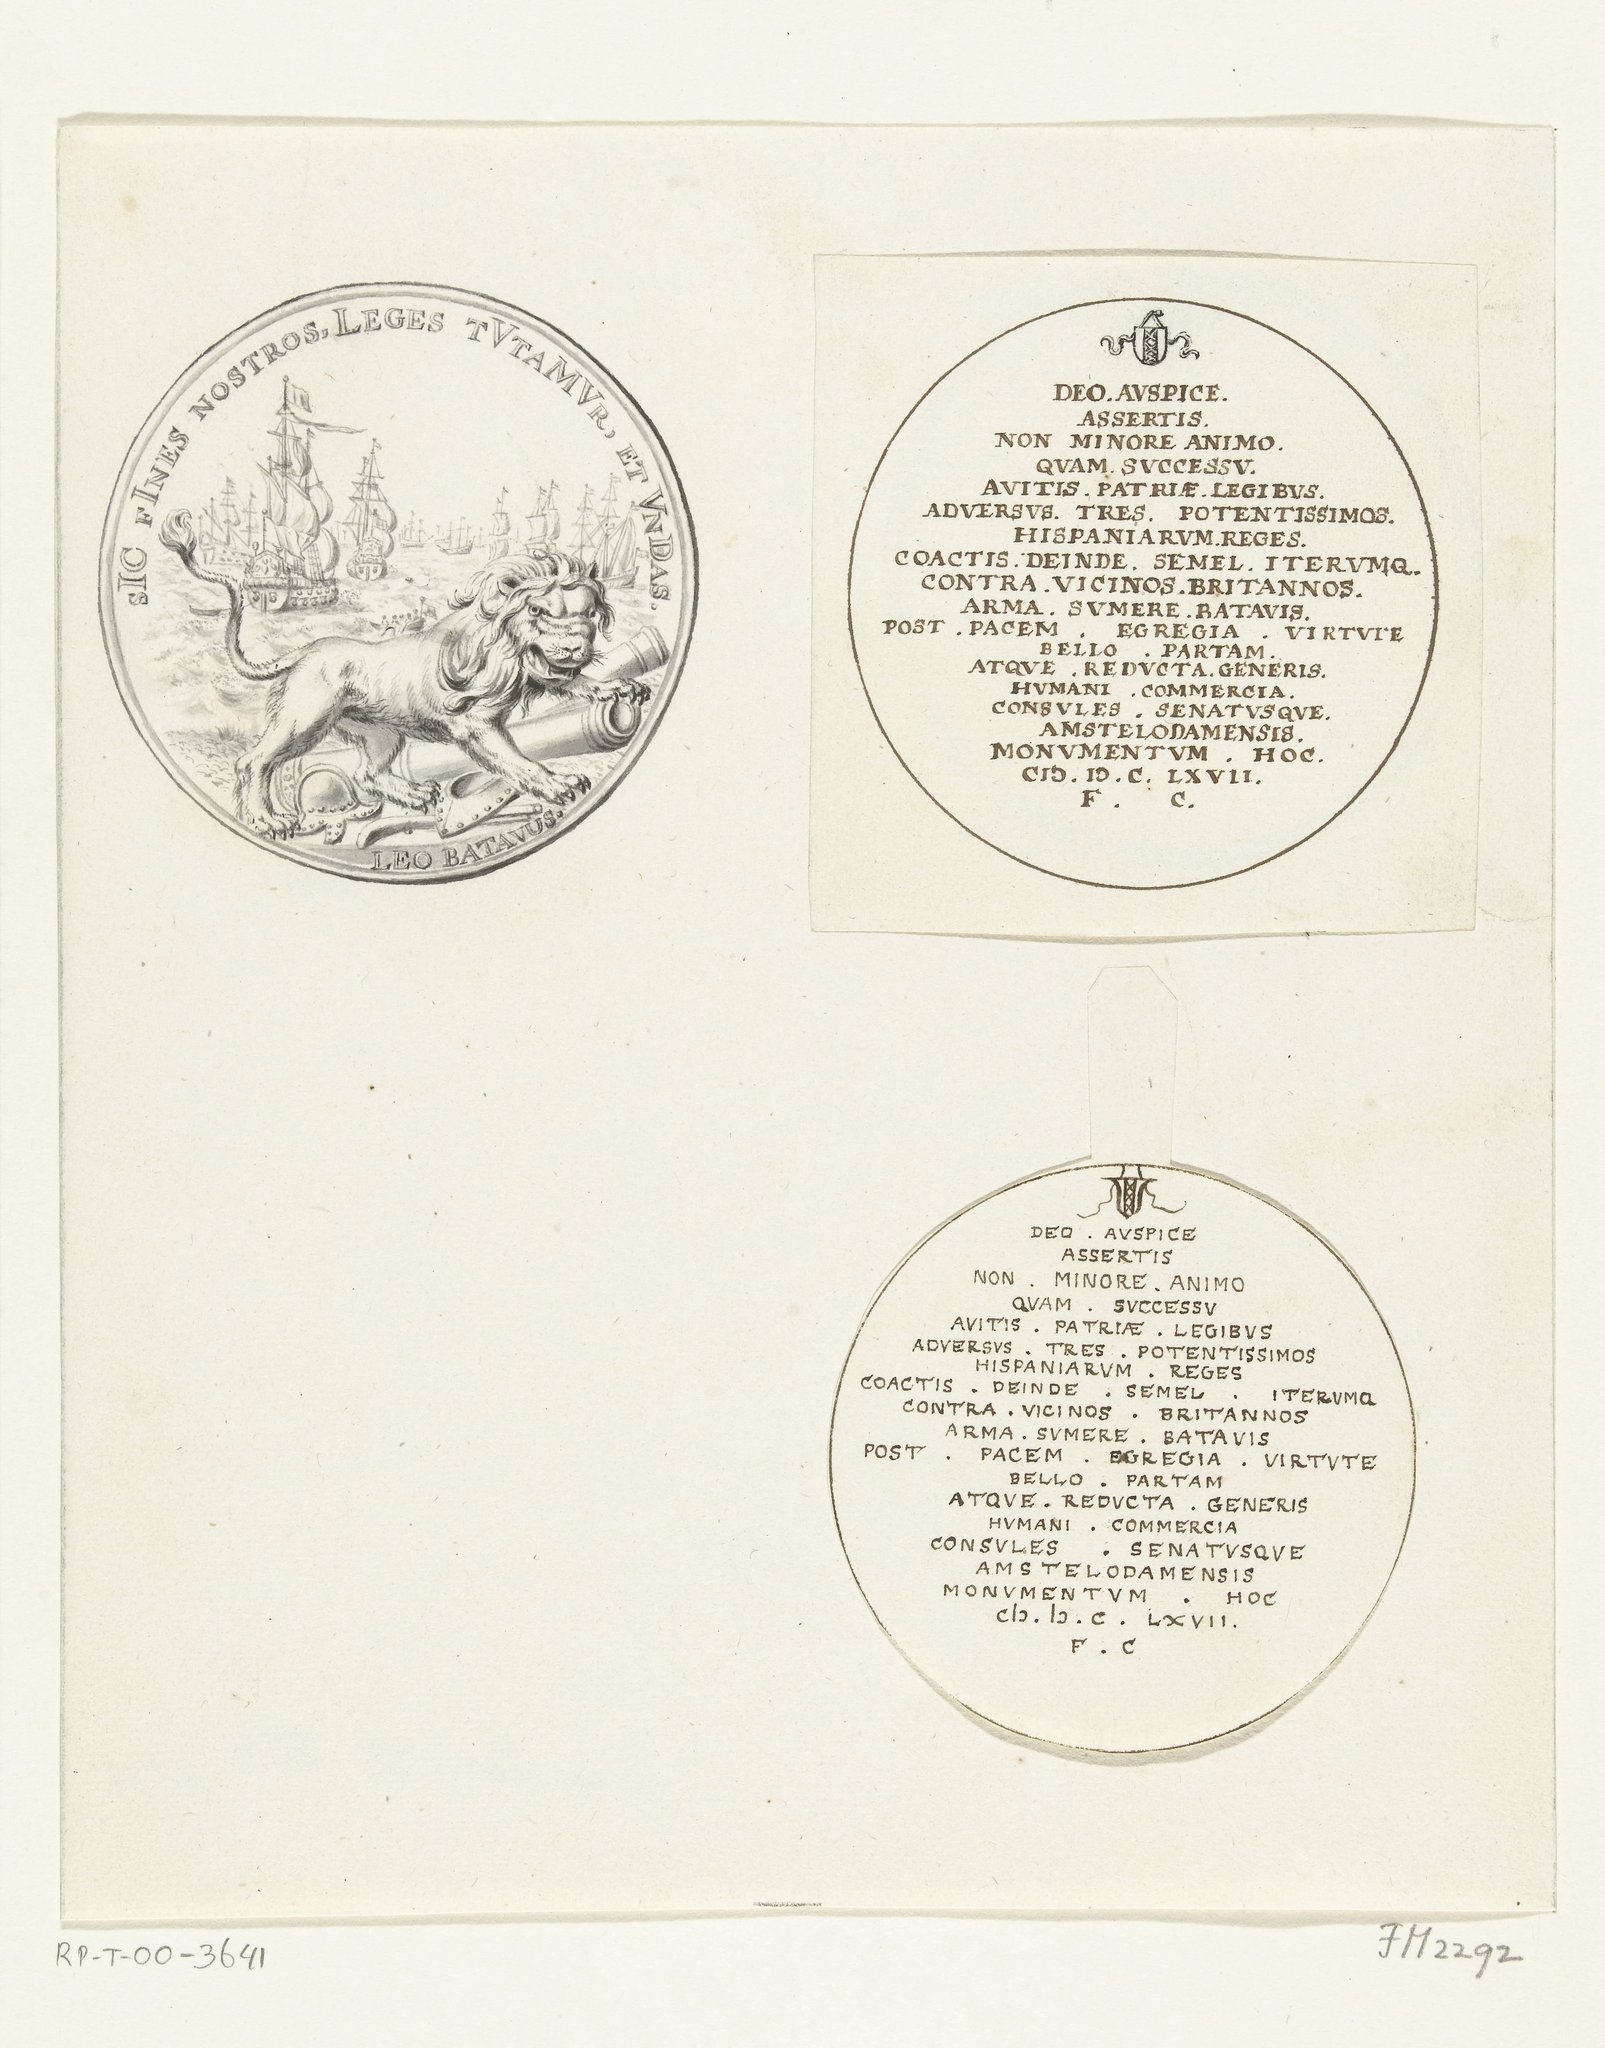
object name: drawing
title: Penning op de Vrede te Breda, 1667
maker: Anonymous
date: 1700-1799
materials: paper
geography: northern netherlands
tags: medal (considered as a piece of sculpture, regardless of its specific function)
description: Een penning op de Vrede te Breda, 1667. Voorzijde en keerzijde (twee keer), uitgeknipt en opgeplakt.